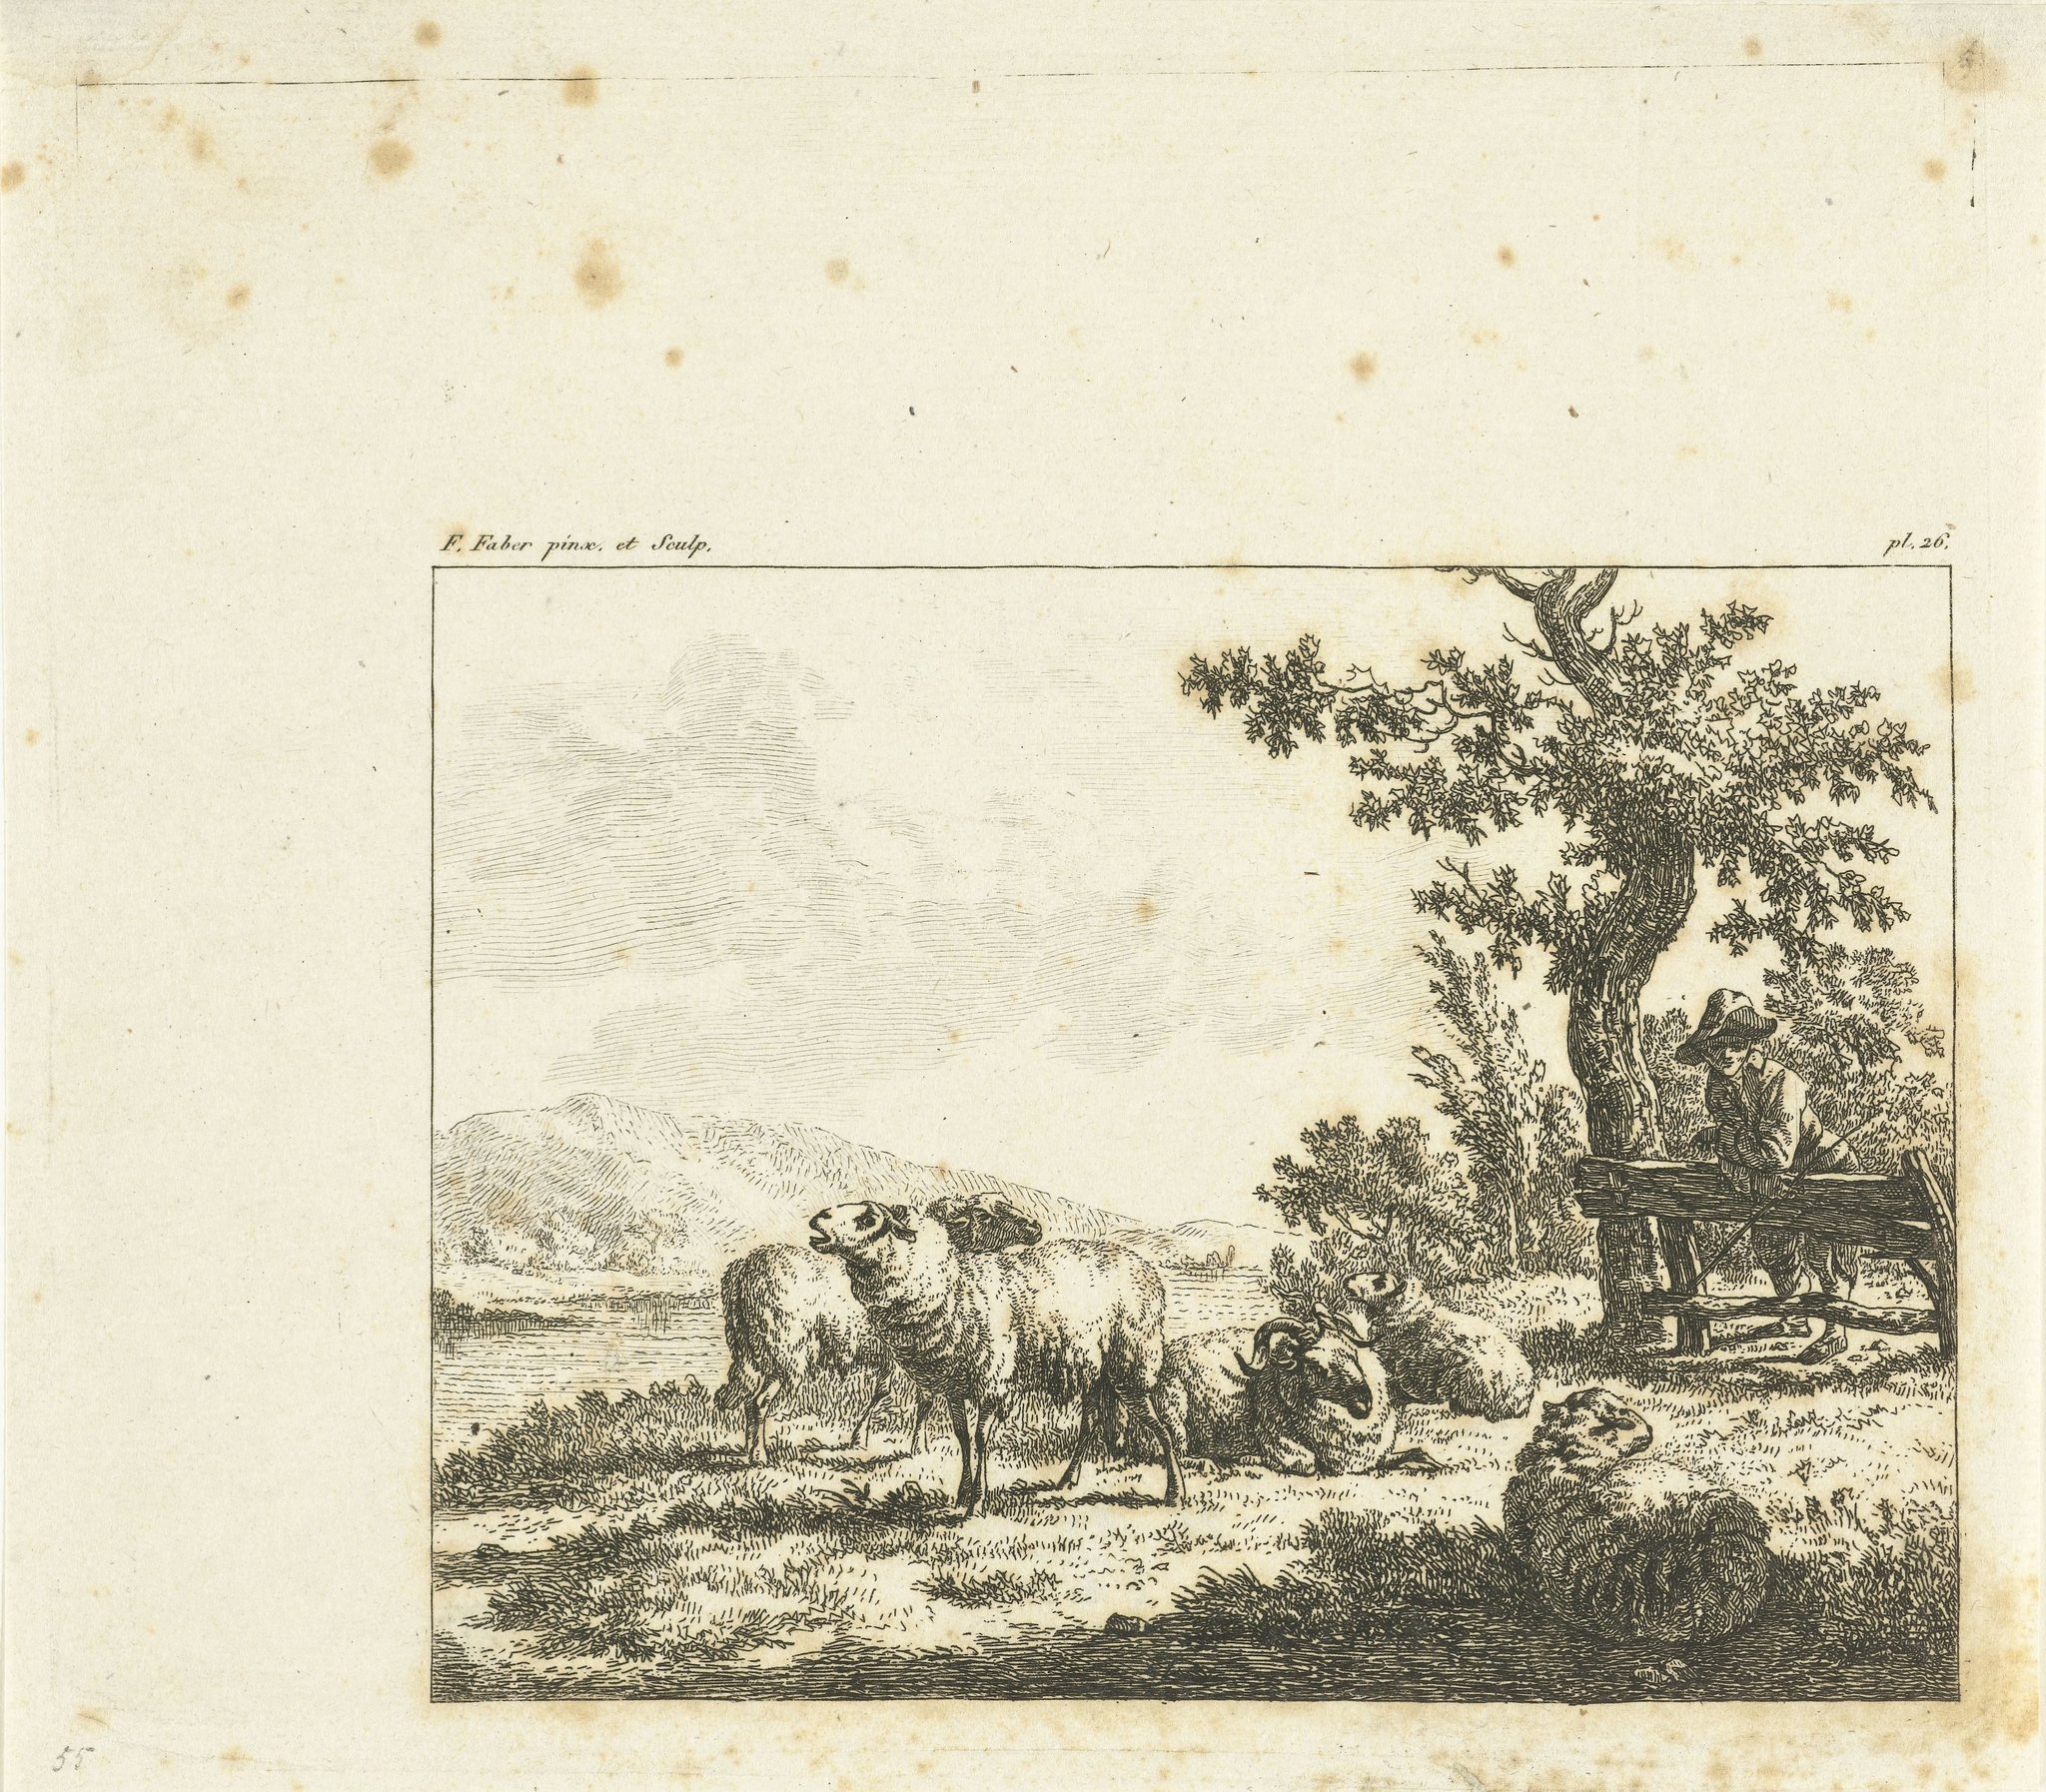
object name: print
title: Schaapherder leunend tegen hek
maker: frédéric théodore faber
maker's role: print maker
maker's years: 1782-1844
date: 1817-1828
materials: paper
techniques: etching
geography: brussels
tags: sheep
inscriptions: collector's mark: Lugt 2228, collector's mark: Lugt 1485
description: Vier schapen en een ram in het gras bij een rivier. Naast een boom staat de herder tegen het hek geleund.